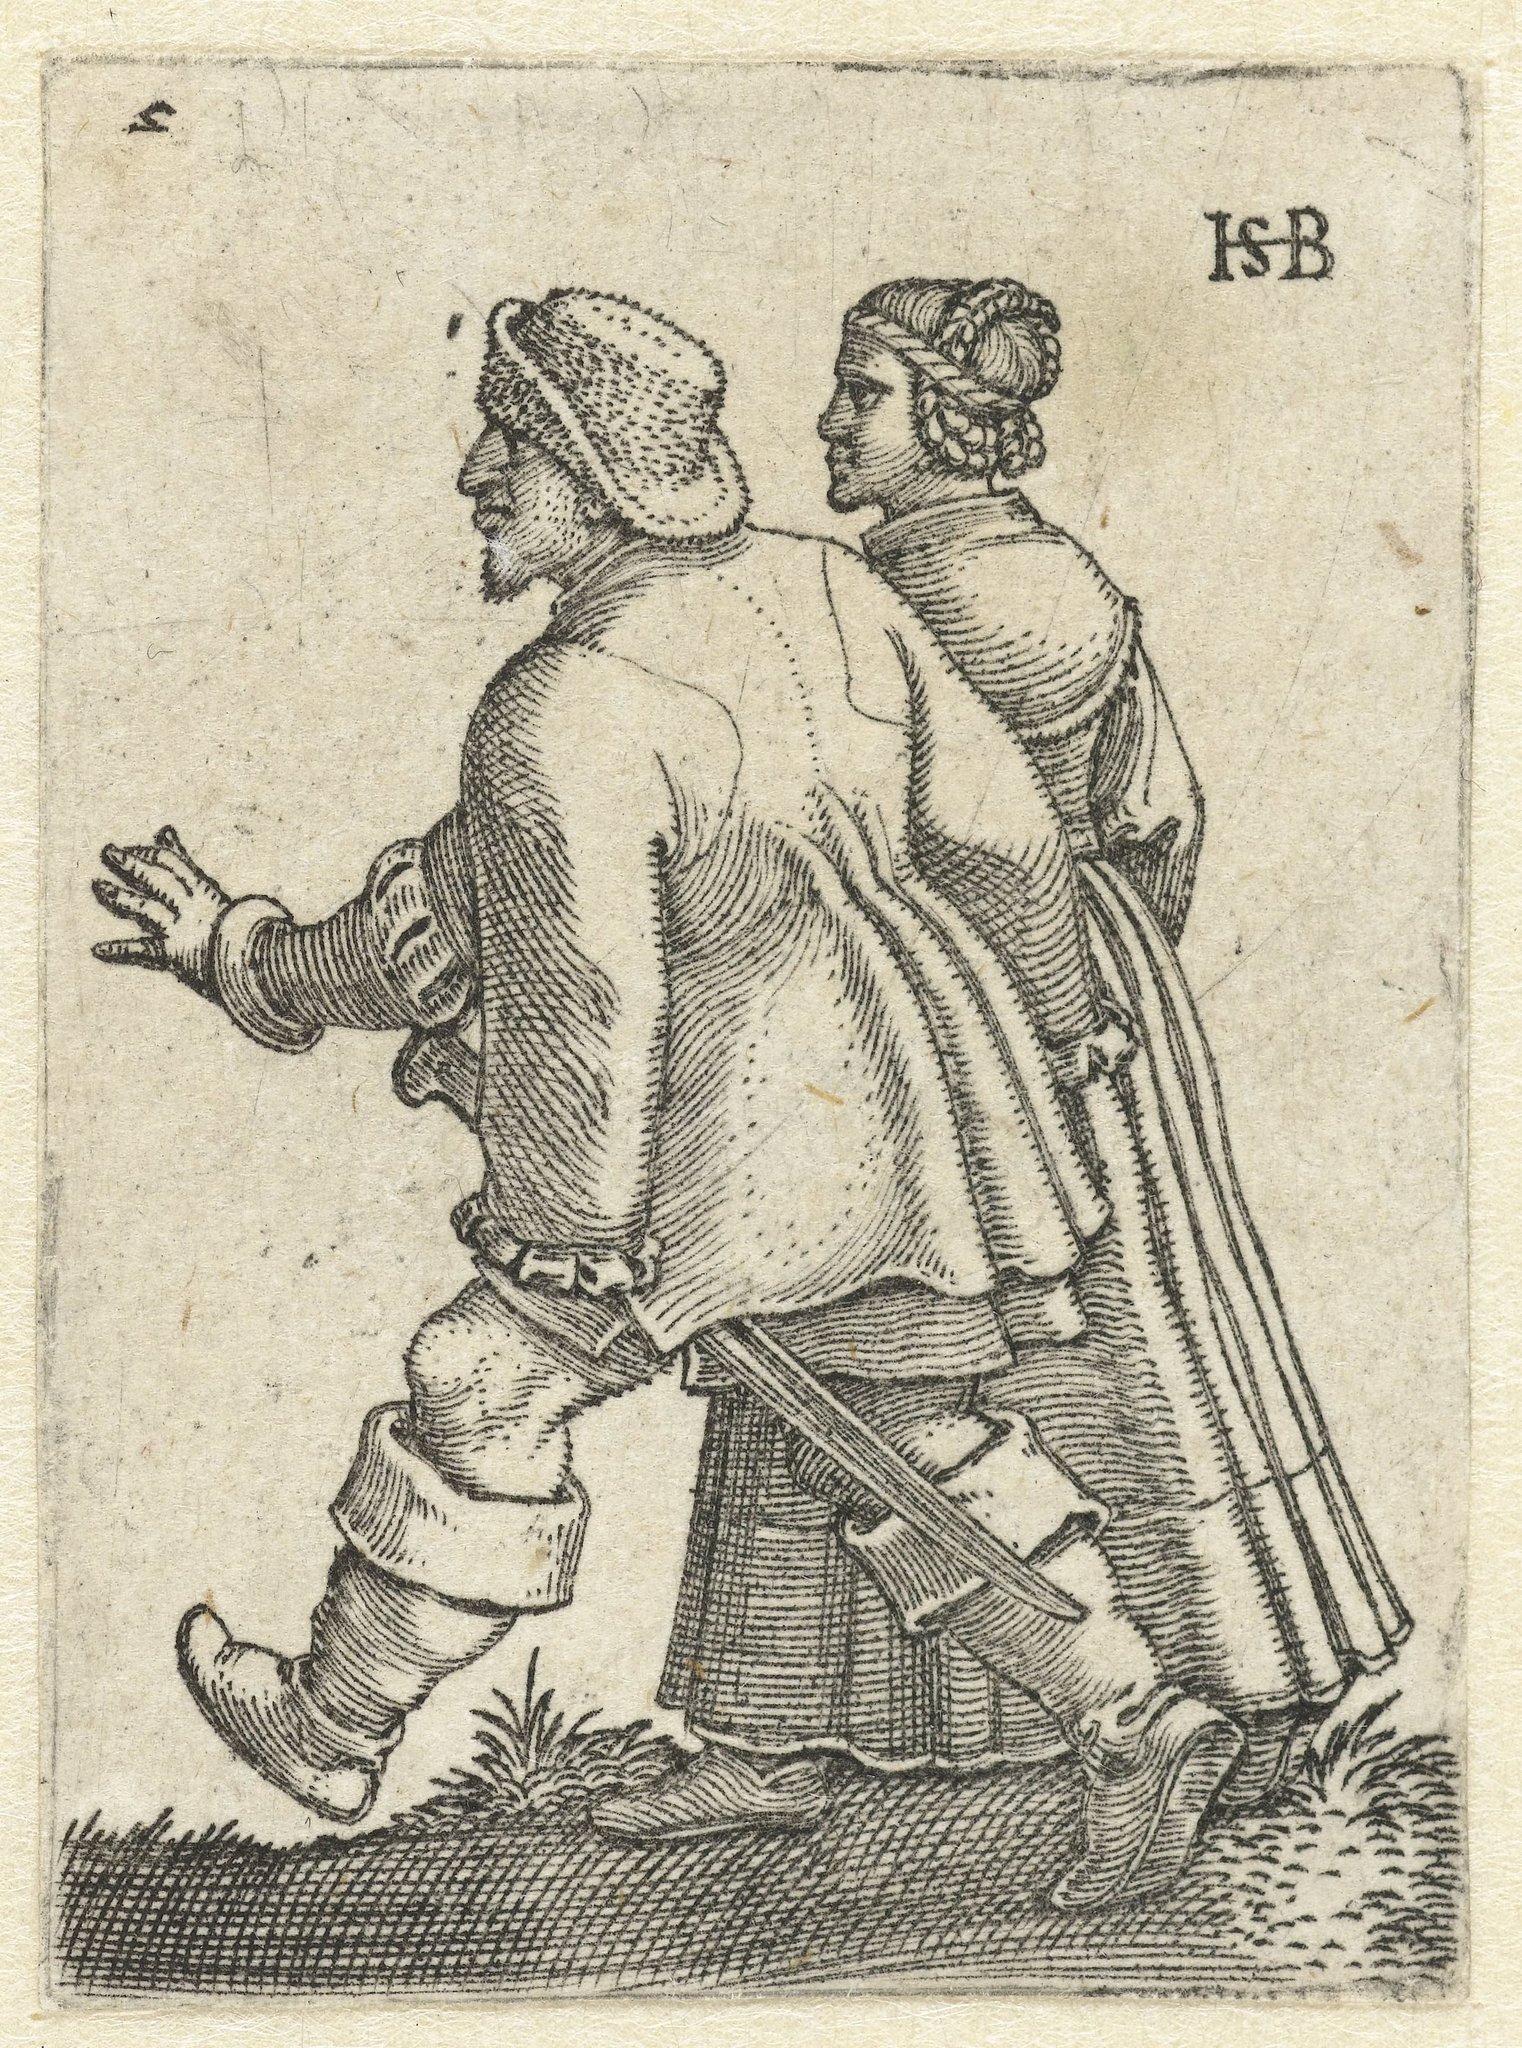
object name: print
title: Dansend boerenpaar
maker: hans sebald beham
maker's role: designer, draughtsman, print maker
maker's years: 1500-1550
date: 1537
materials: paper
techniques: engraving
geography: frankfurt am main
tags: (annual) fair, trade fair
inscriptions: collector's mark: Lugt 2228a